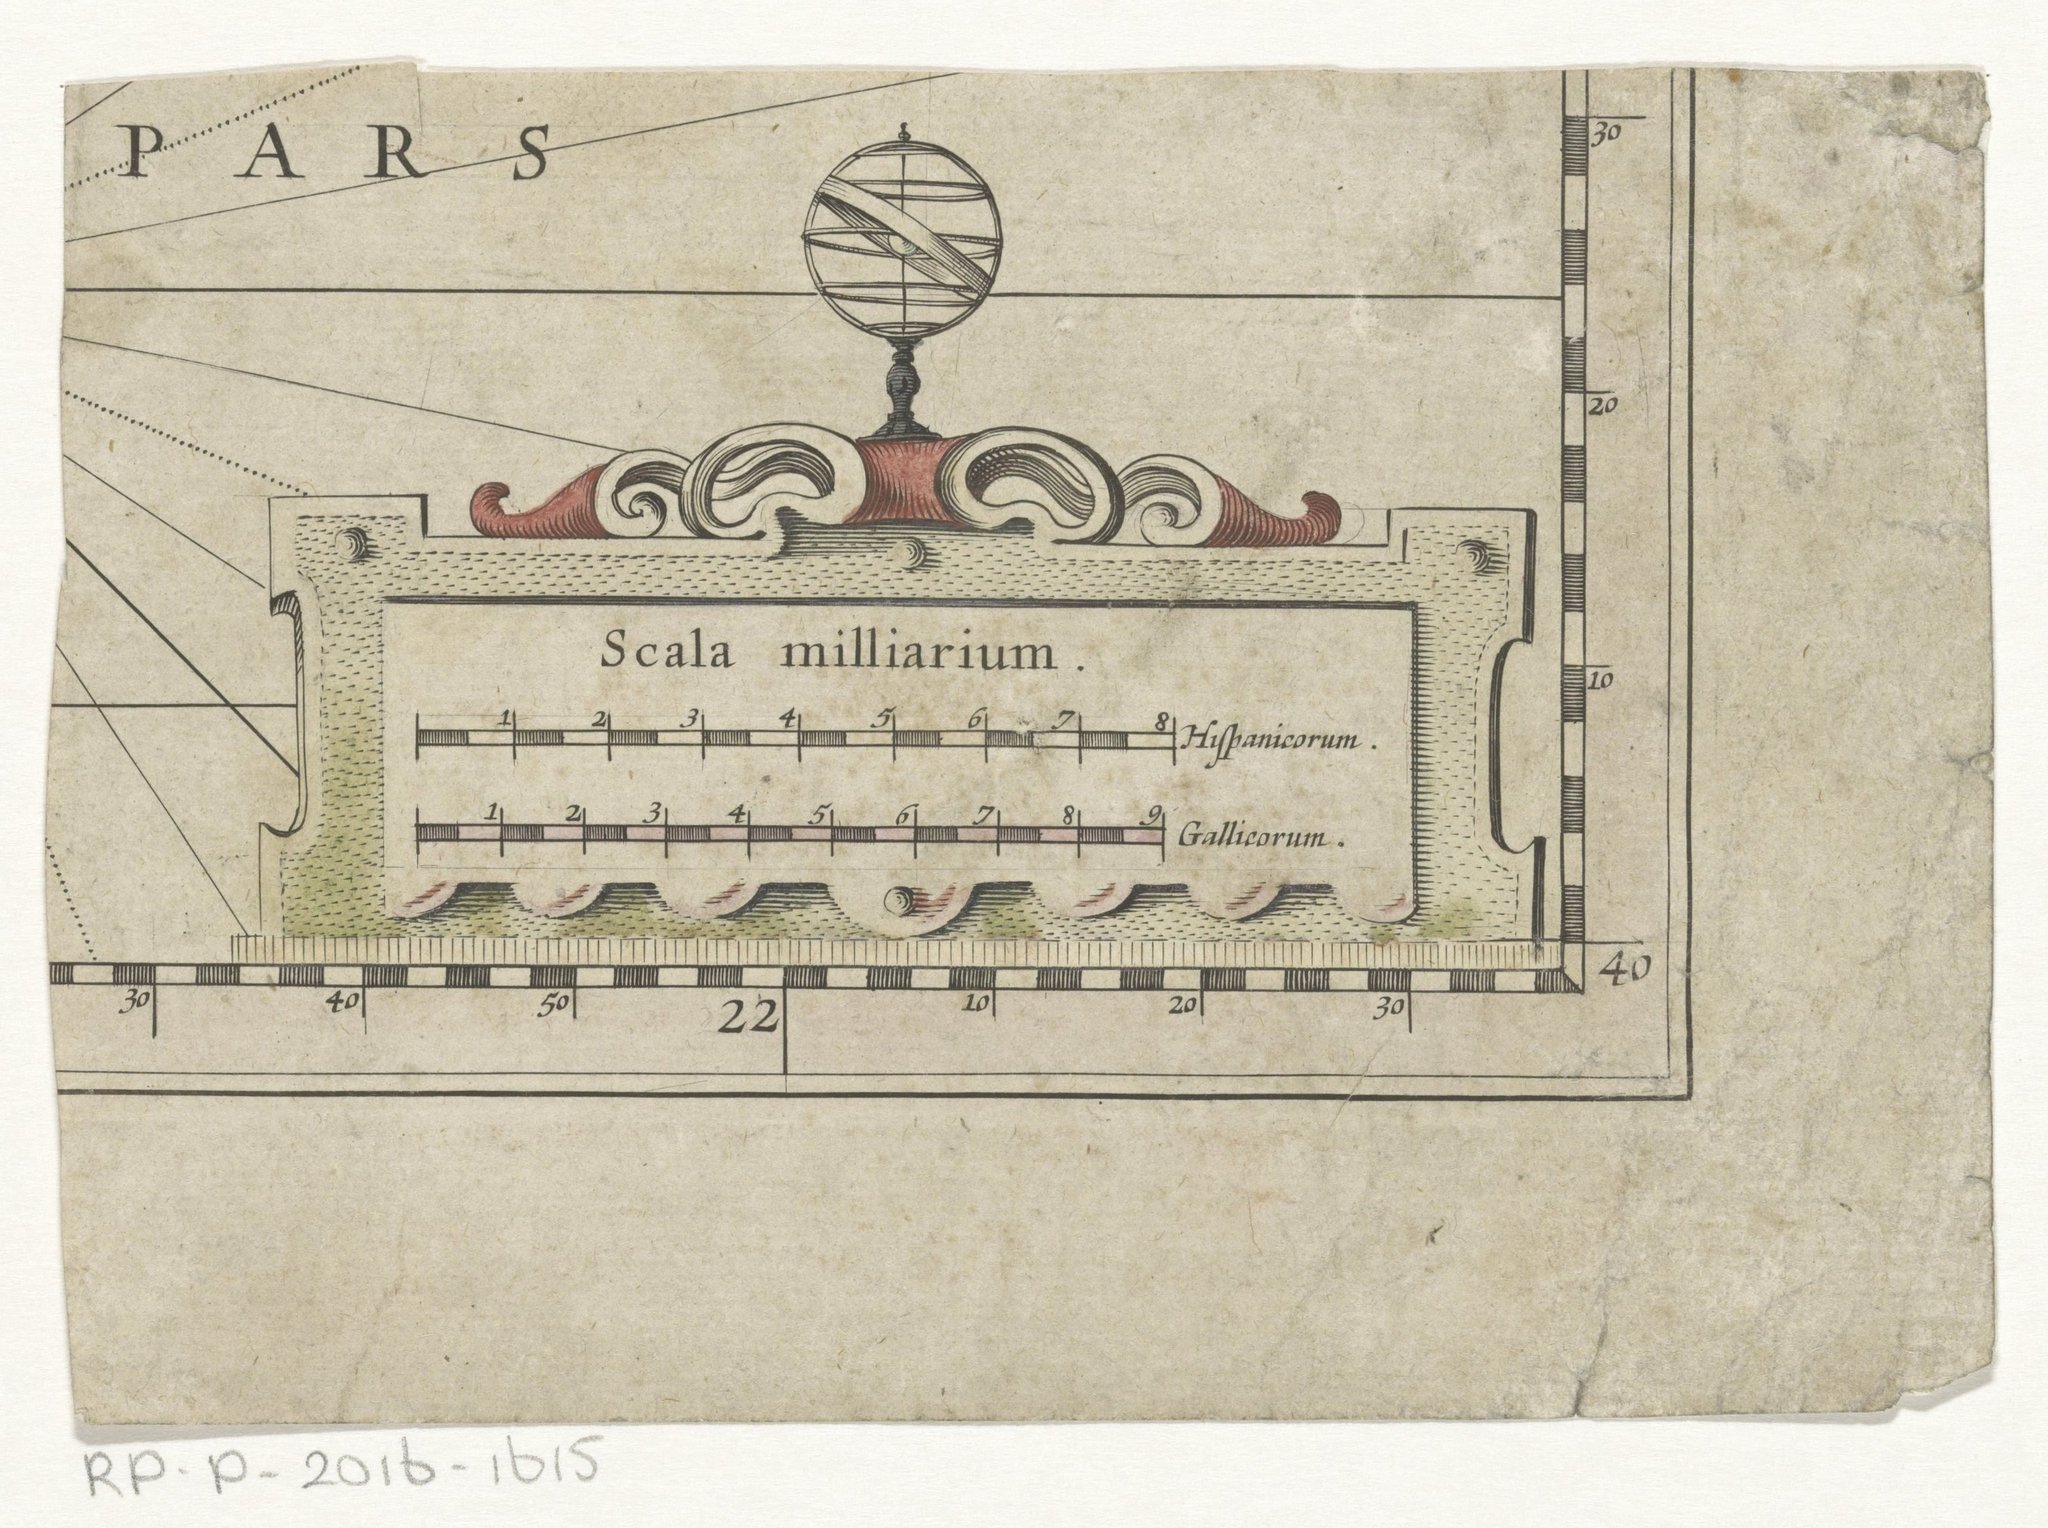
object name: print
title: Schaalverdeling waarboven een armillarium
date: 1634-1635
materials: paper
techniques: engraving, hand coloring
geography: amsterdam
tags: armillary sphere, skeleton celestial globe, scales of notation (arithmetic)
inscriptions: collector's mark: Lugt 2228